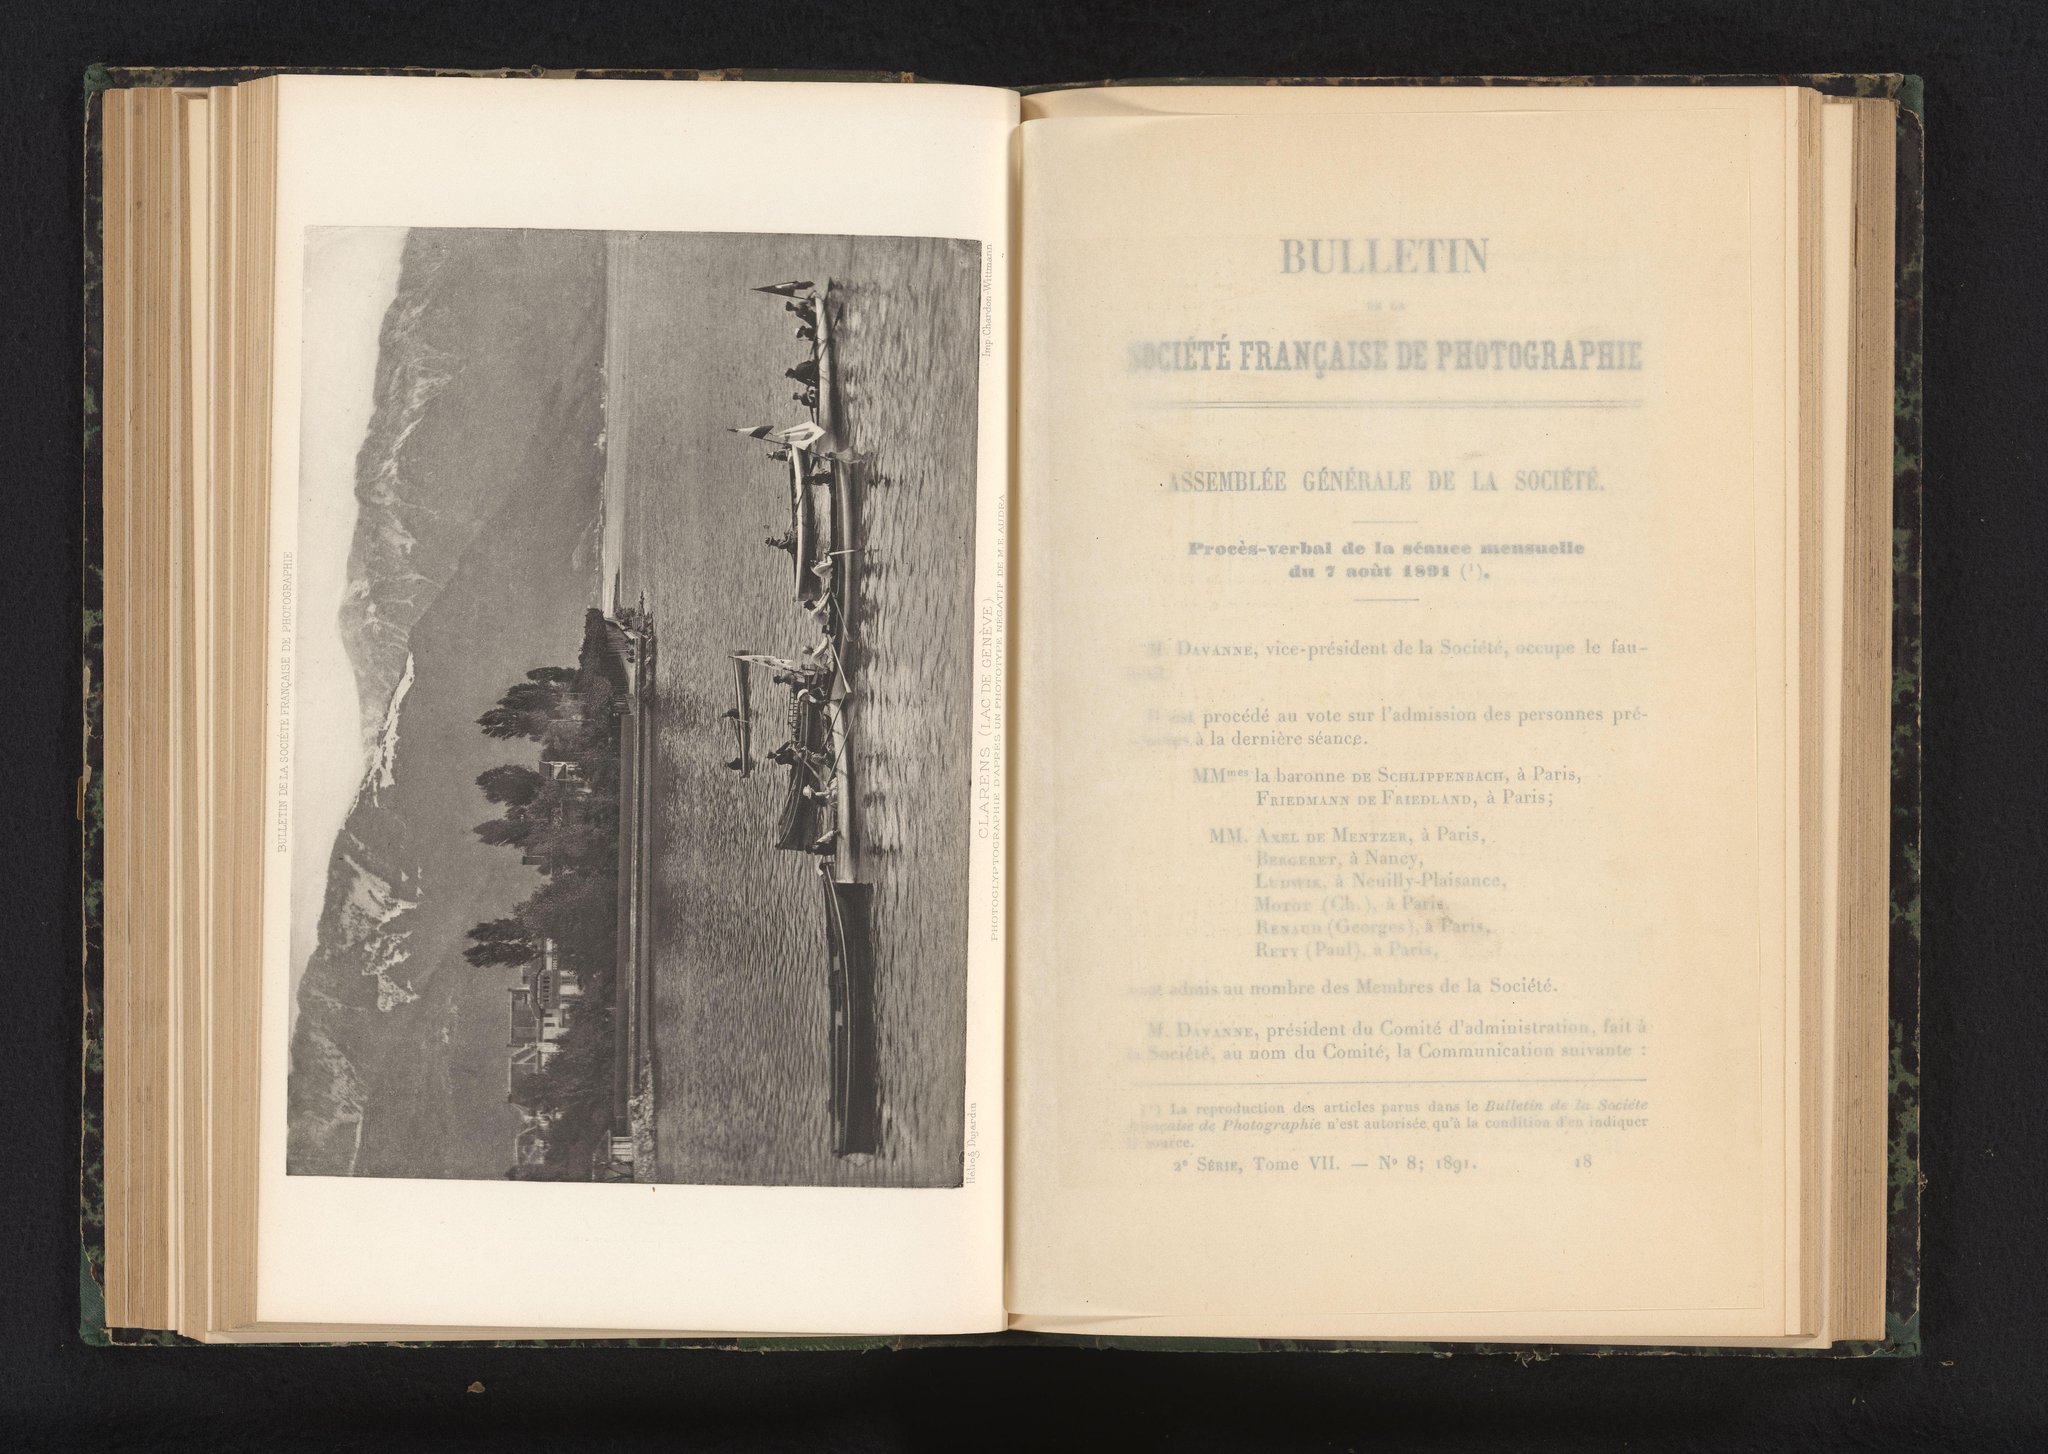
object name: photomechanical print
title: Roeiboten op het Meer van Genève bij Clarens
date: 1886-1891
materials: paper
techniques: photoaquatint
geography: clarens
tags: lake, rowing facing backward, pulling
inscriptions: inscription: ‘Photoglyptographie d'après un phototype négatif de M. E. Audra’